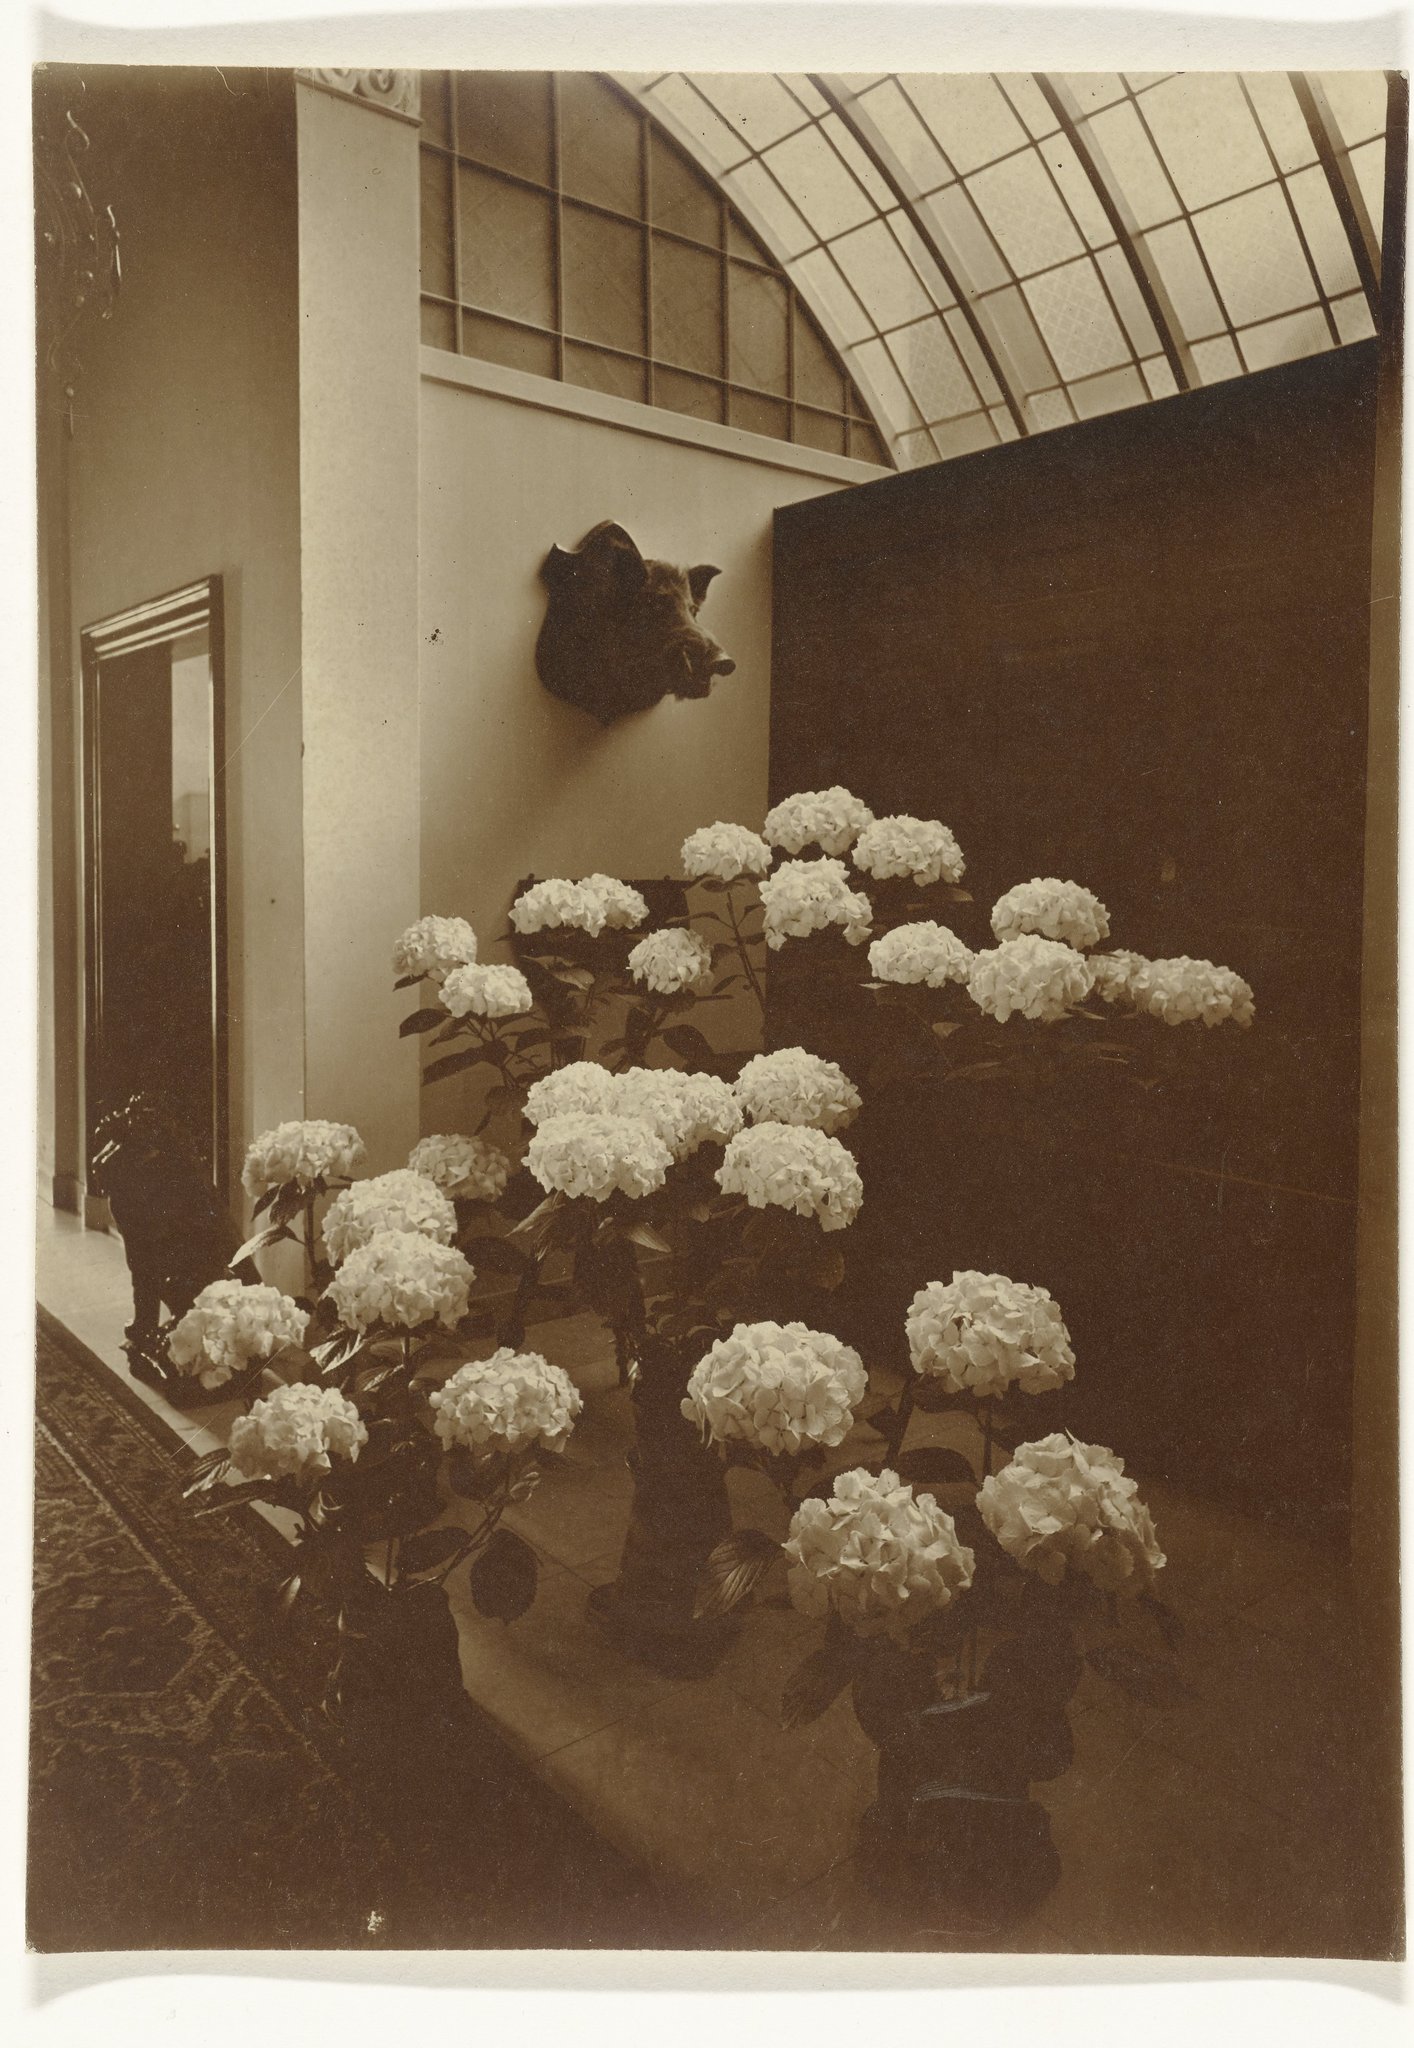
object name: photograph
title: Bloeiende Hortensia in een binnenruimte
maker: richard tepe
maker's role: fotograaf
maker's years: 1864-1952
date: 1900-1930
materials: photographic support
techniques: gelatin silver print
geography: netherlands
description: De planten staan in een vestibule, aan de wand hangt een opgezette kop van een wildzwijn